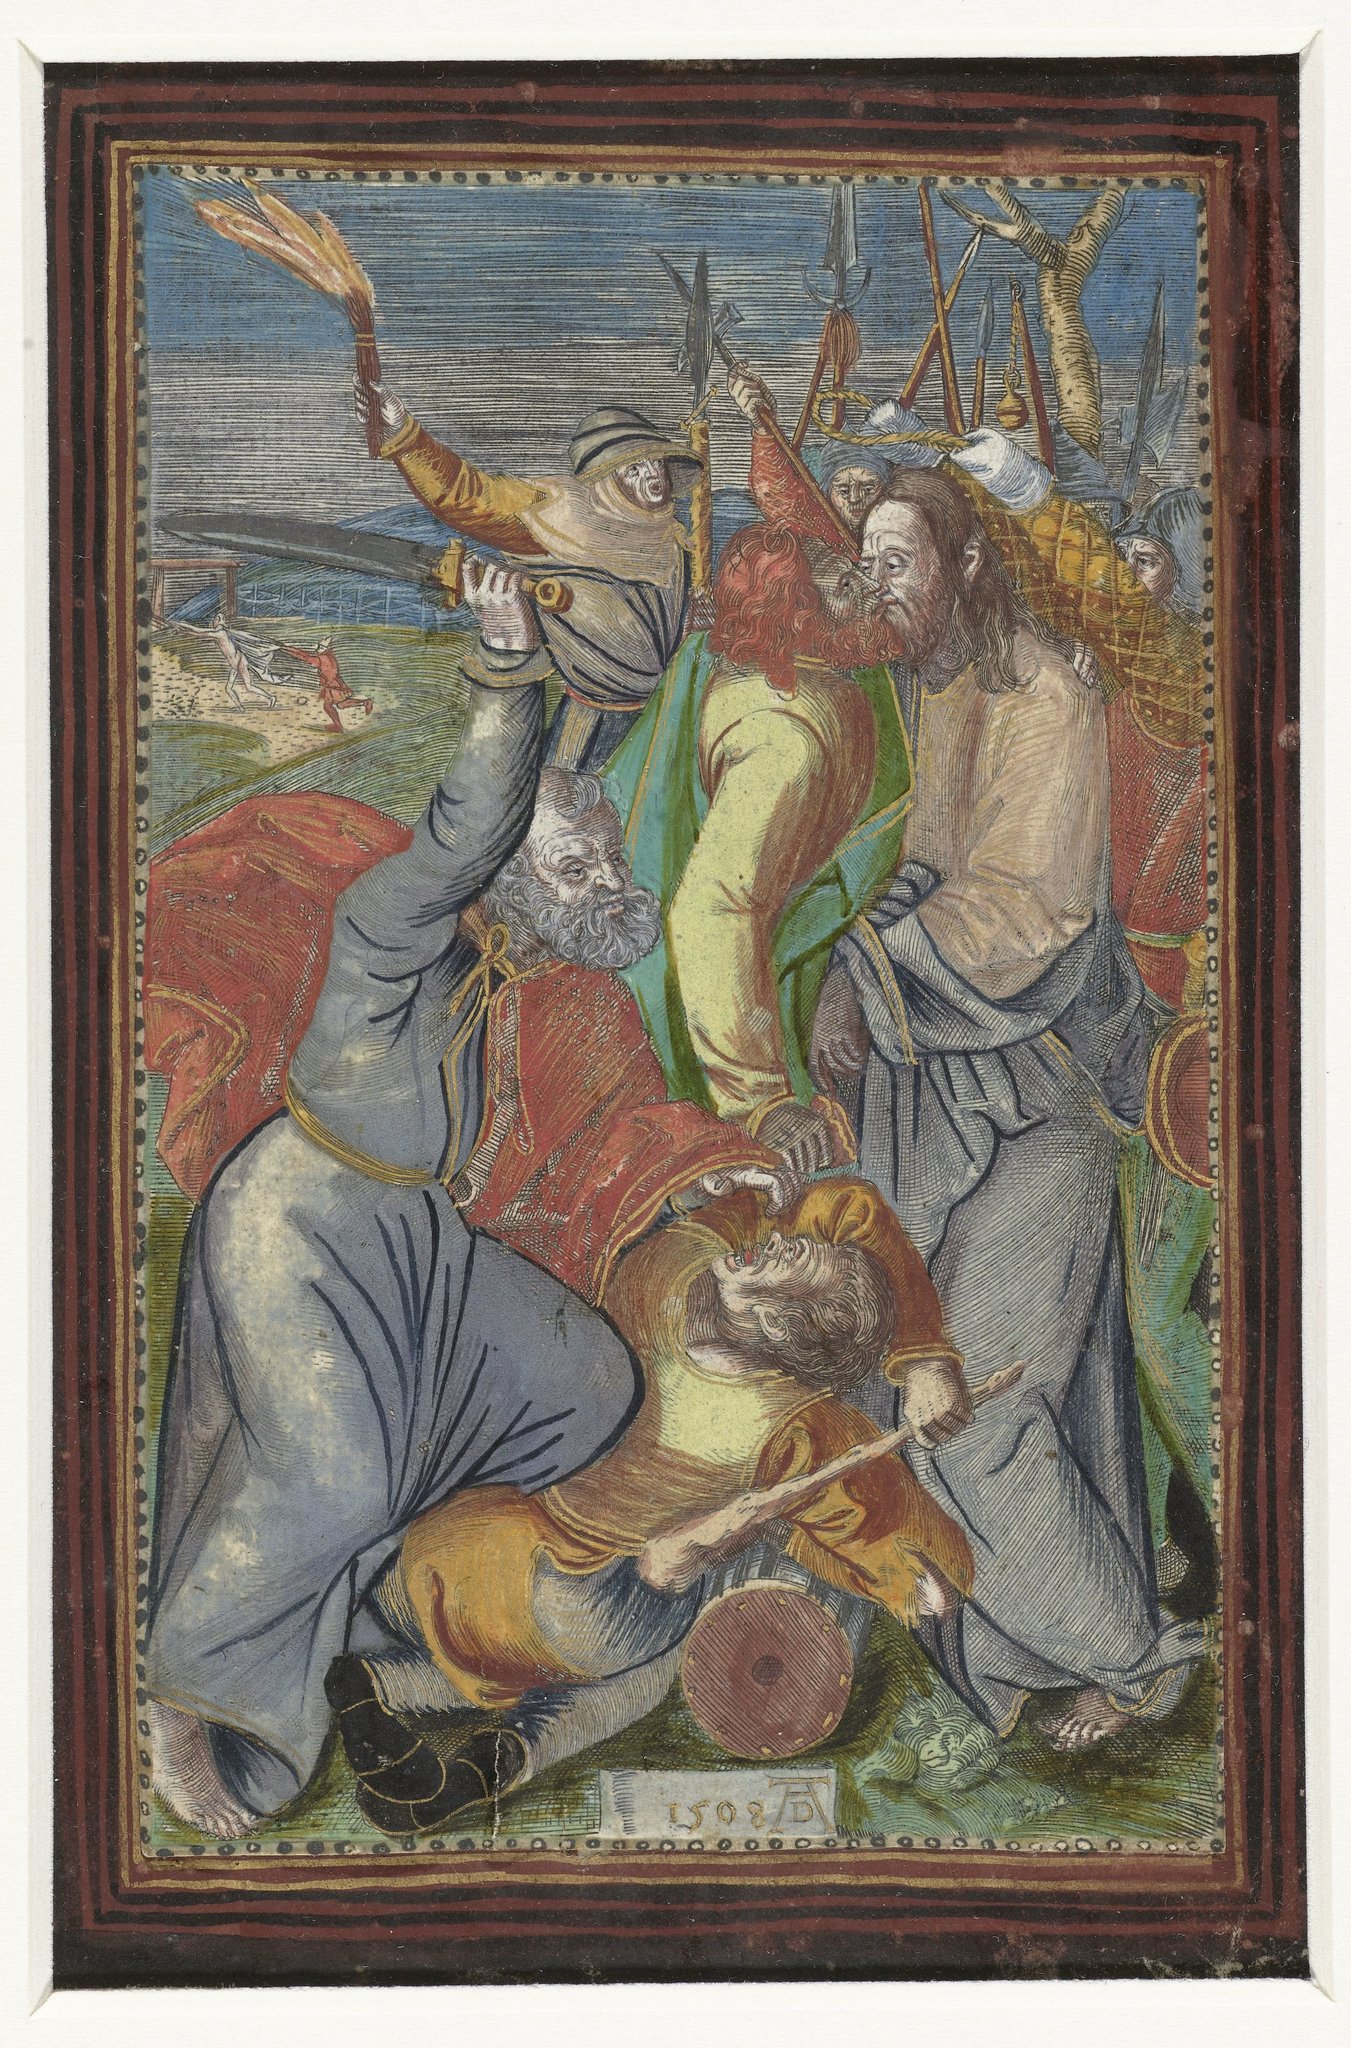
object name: print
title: De gevangenneming van Christus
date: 1508-1599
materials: paper, parchment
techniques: engraving, hand coloring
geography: germany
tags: peter draws his sword and cuts off malchus' ear, the kiss of judas: accompanied by soldiers with torches and lanterns, he kisses christ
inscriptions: monogram and date: ‘1508 AD’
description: Christus wordt door Judas met een kus verraden. Soldaten staan achter Christus klaar om hem mee te voeren. Op achterzijde 9 regels Latijnse tekst in boekdruk. Deze prent is onderdeel van een serie prenten met scènes uit het Lijdensverhaal, kopieën naar Albrecht Dürers Gegraveerde Passie.